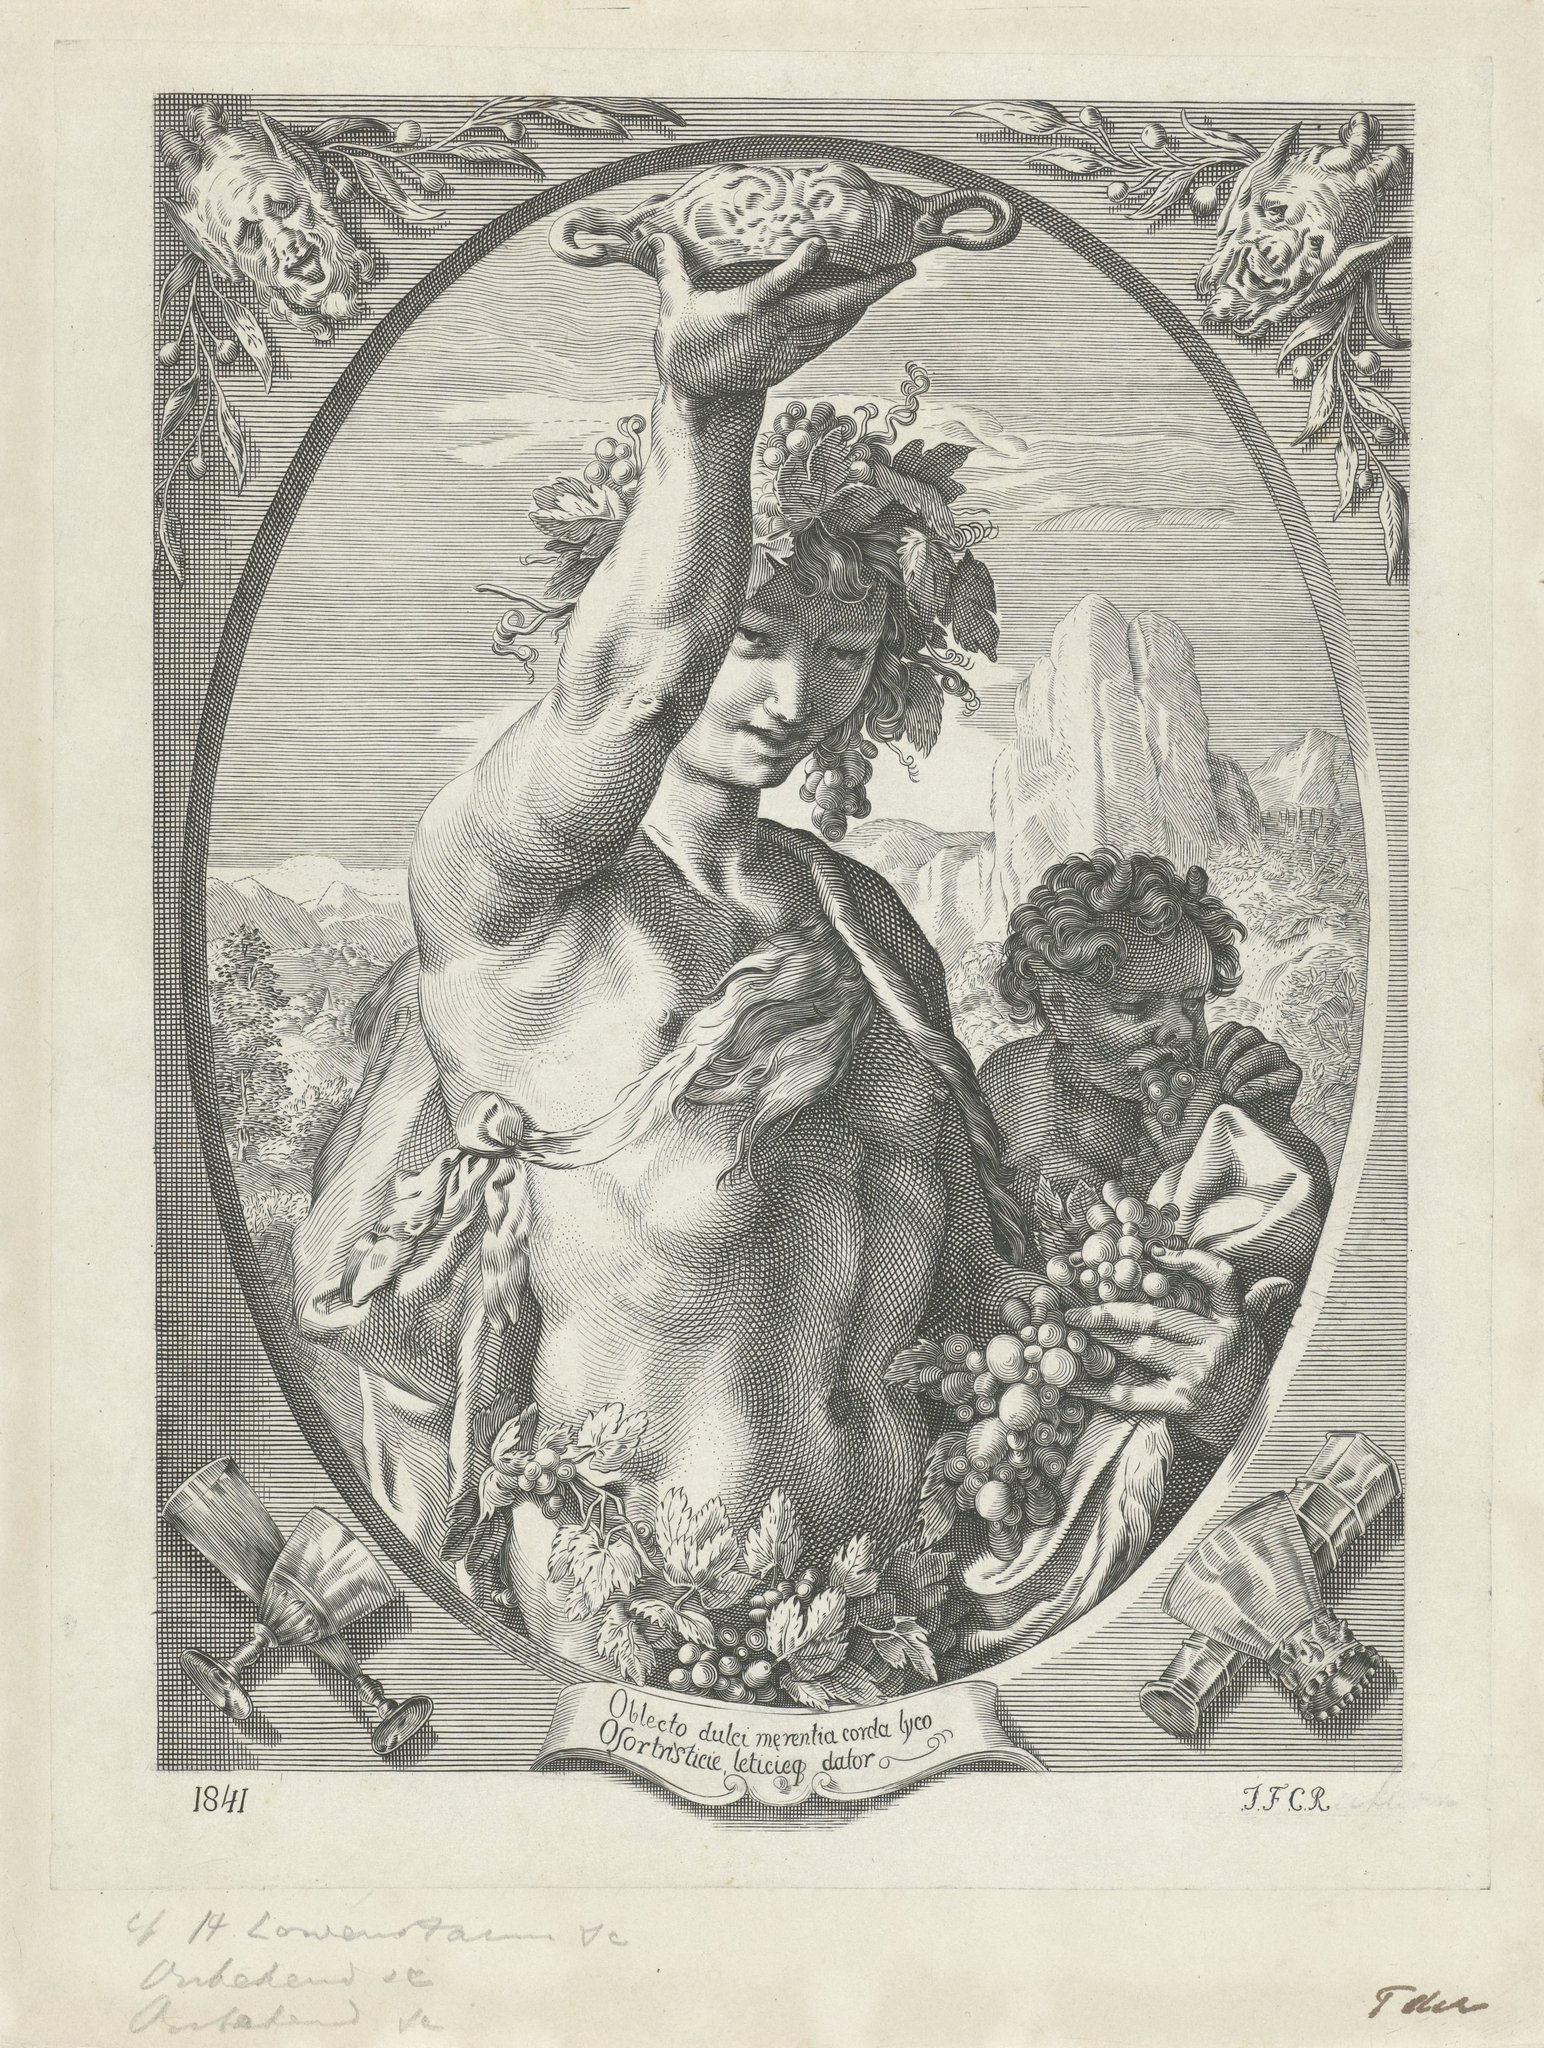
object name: print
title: Bacchus en Pan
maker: jan frederik christiaan reckleben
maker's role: print maker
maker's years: 1819-1879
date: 1841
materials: paper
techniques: engraving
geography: haarlem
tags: (story of) bacchus (dionysus), liber, (story of) pan - infancy, upbringing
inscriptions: date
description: Voor een landschap staat Bacchus met een tros druiven en een drinkschaal in de hand. Naast hem staat Pan als kind met een druiventros. In de hoeken van de omlijsting zijn twee saters en diverse drankglazen weergegeven.